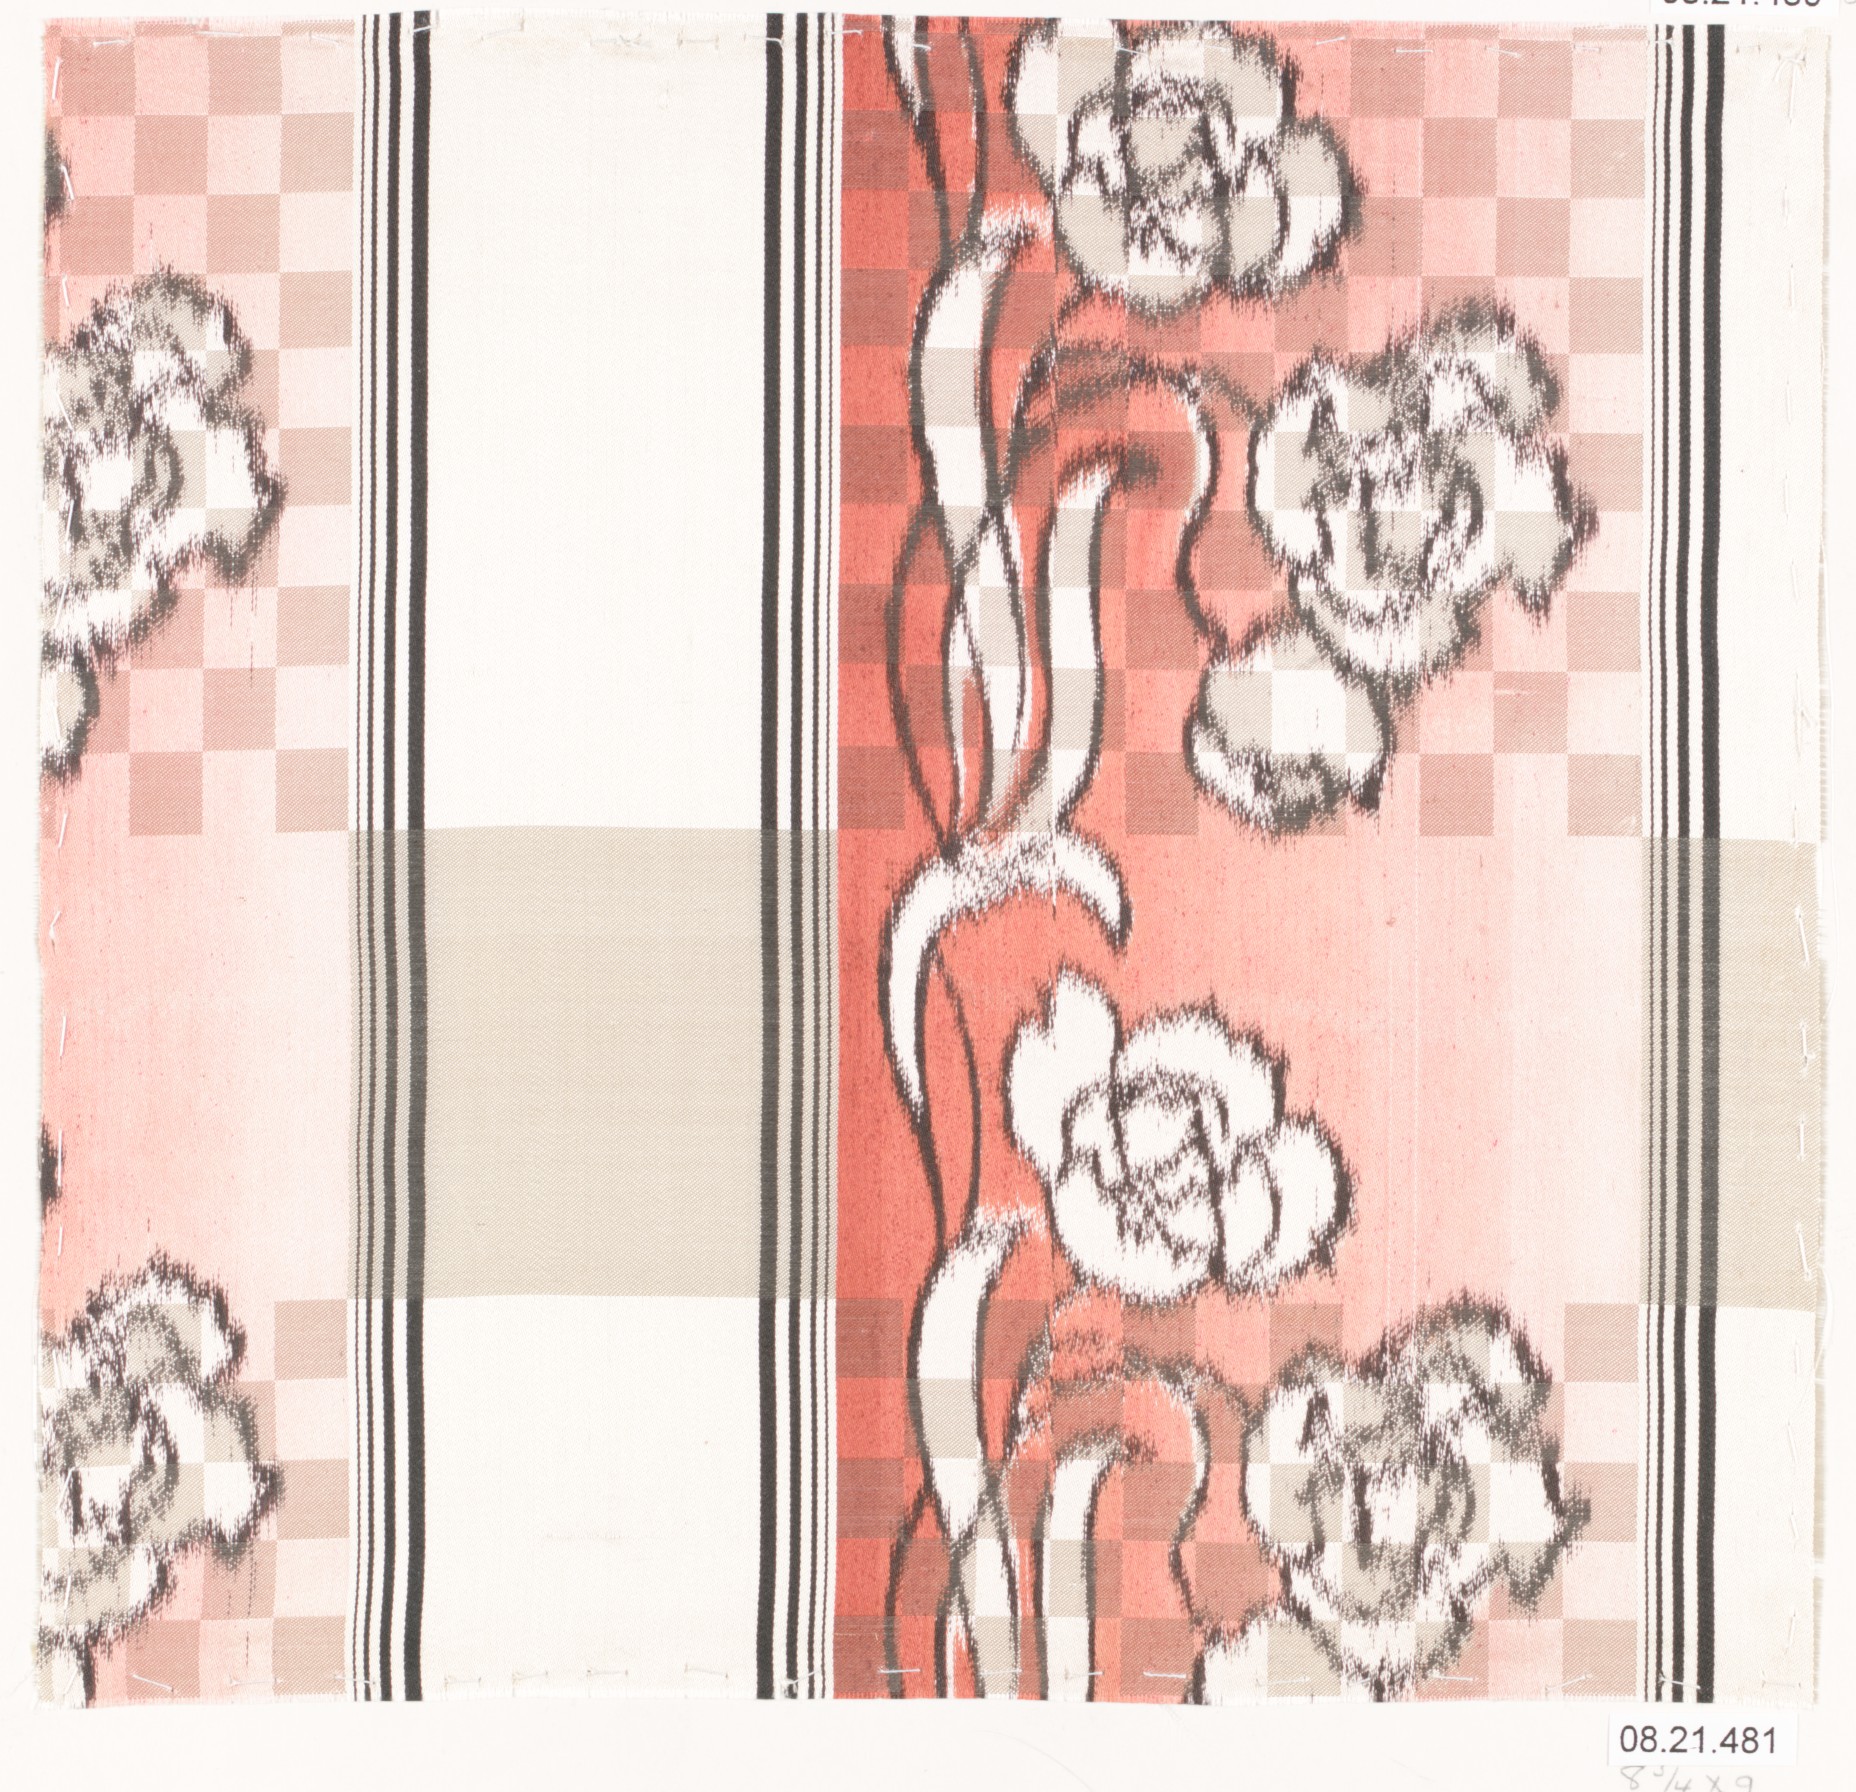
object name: textile sample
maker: Anonymous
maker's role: designer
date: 1900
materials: silk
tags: flowers